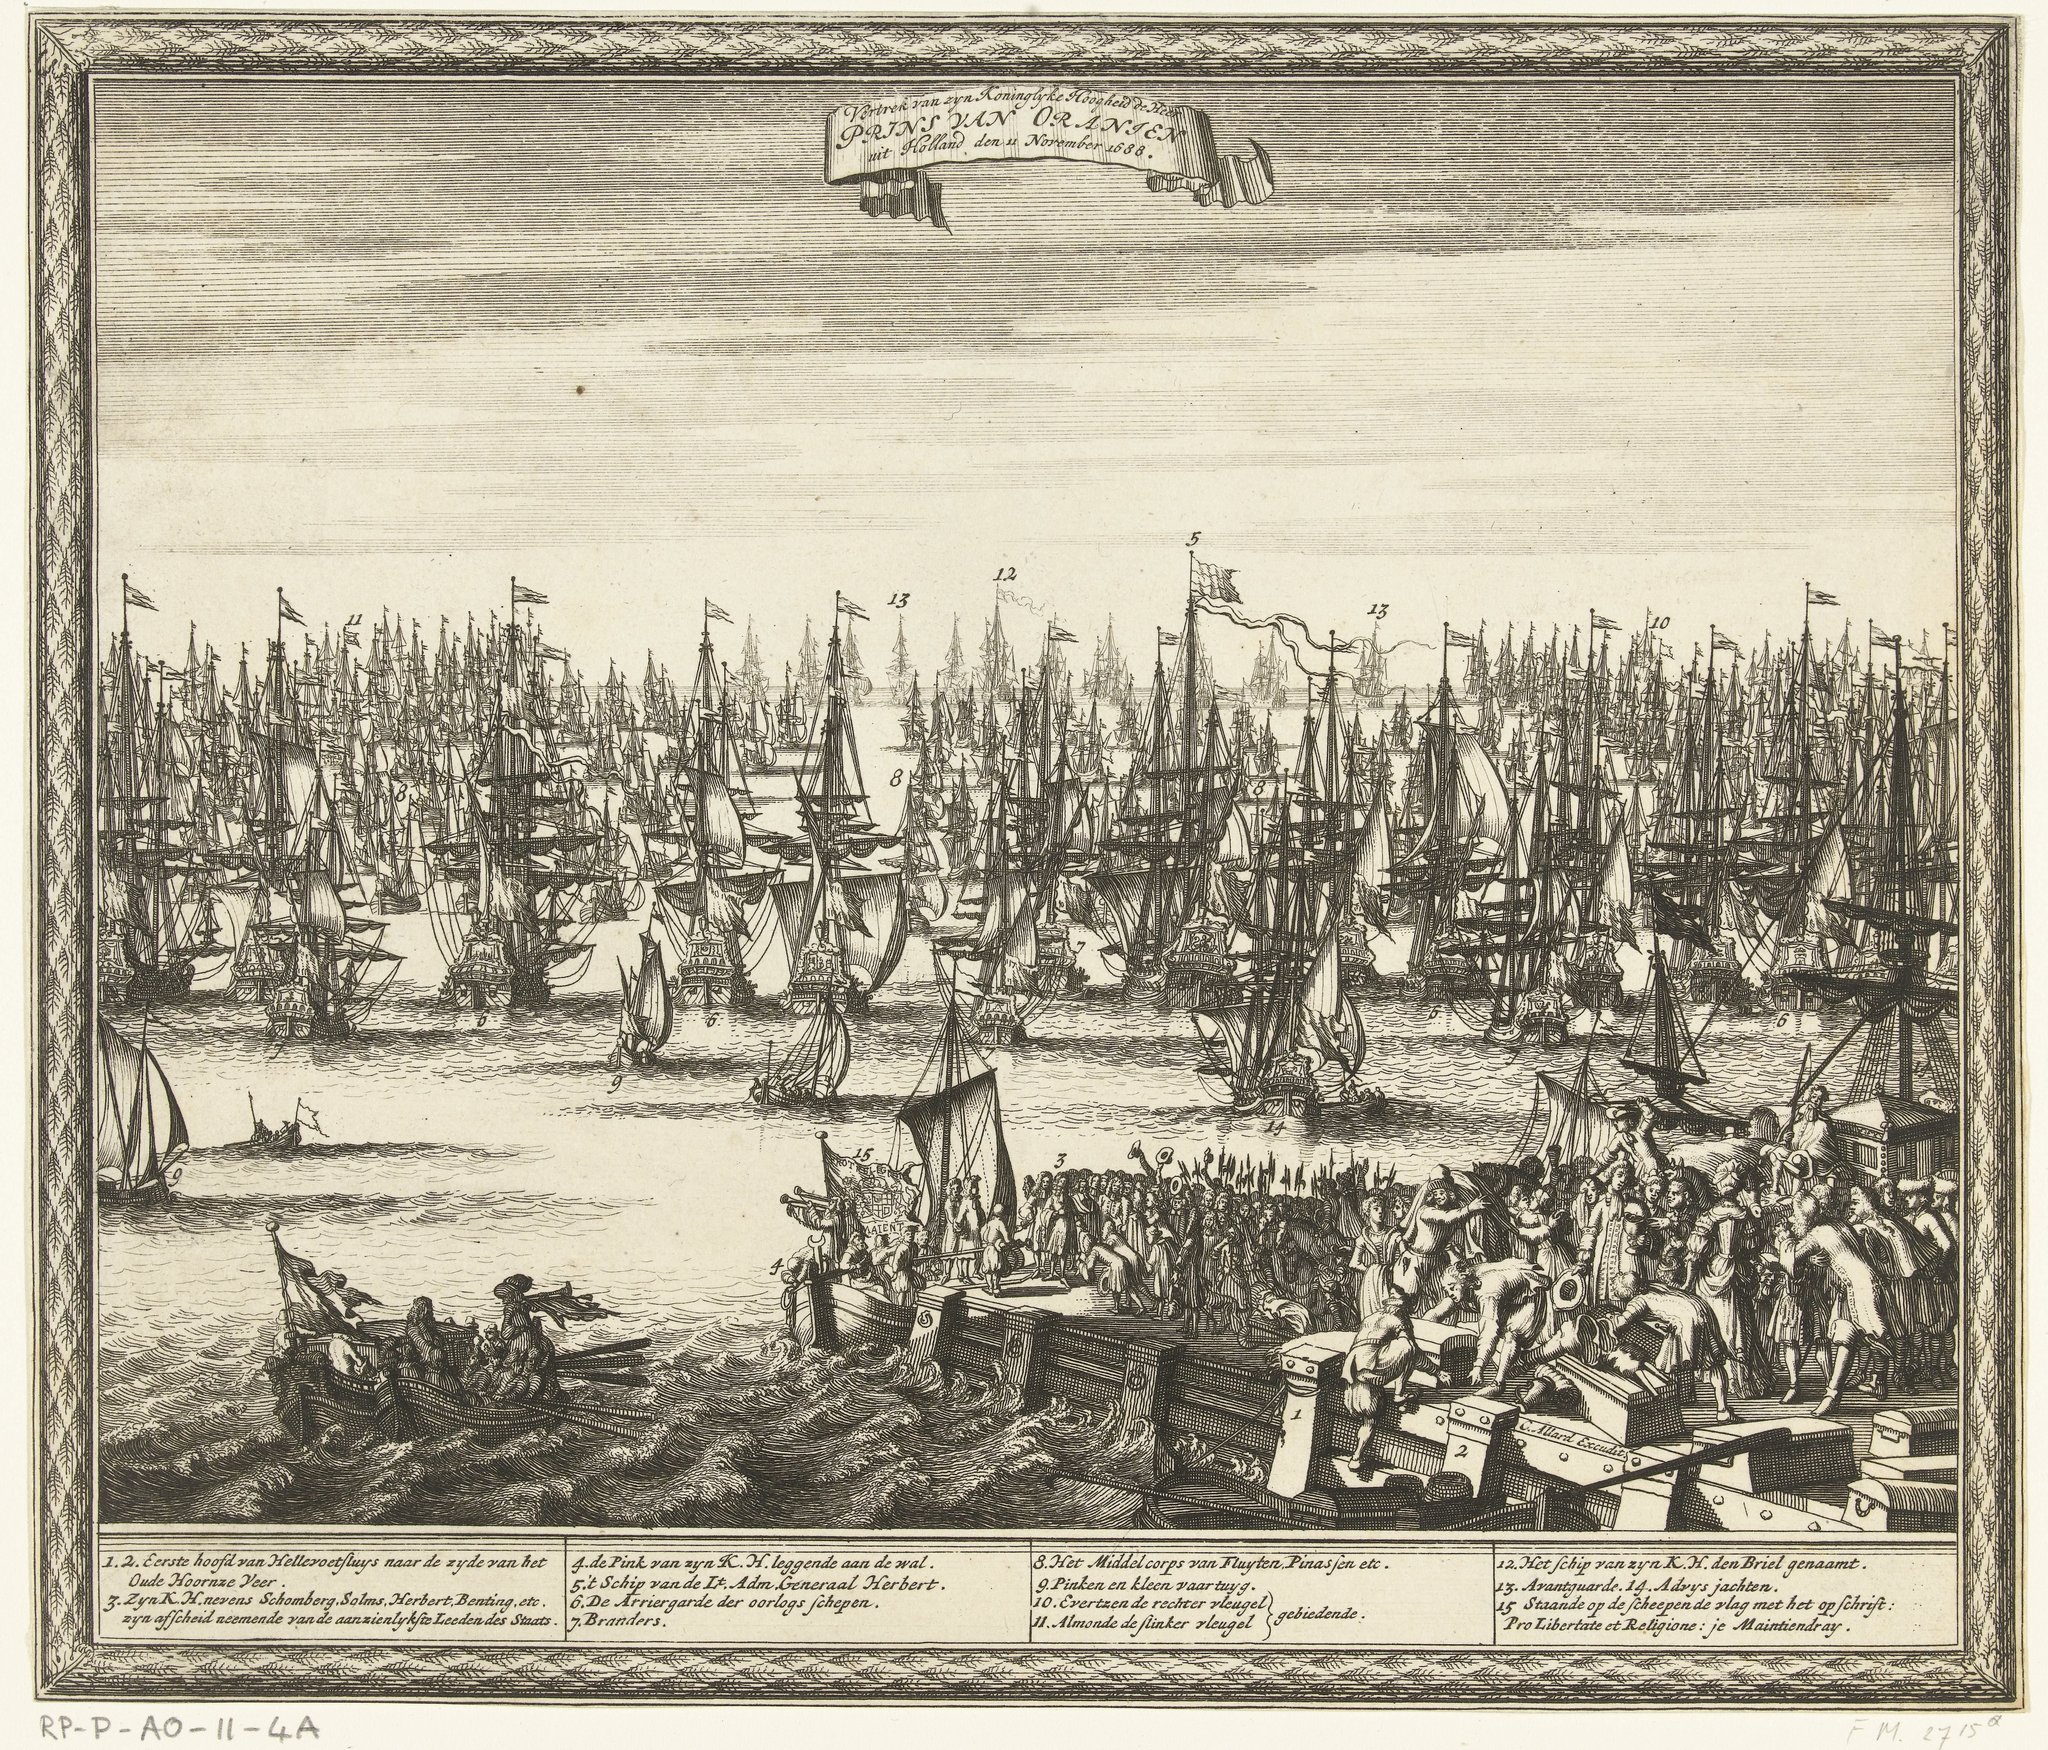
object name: print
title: Vertrek van Willem III vanuit Hellevoetsluis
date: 1688-1690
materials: paper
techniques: etching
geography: amsterdam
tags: the hague, william iii (prince of orange and king of england, scotland, and ireland), hellevoetsluis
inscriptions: collector's mark: Lugt 2228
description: Gezicht op de vloot van Willem III voor Hellevoetsluis. Willem III staat op de kade op het punt om in een boot te stappen die hem naar zijn schip zal brengen. Met een legenda van vier kolomen van elk vier regels in het Nederlands.